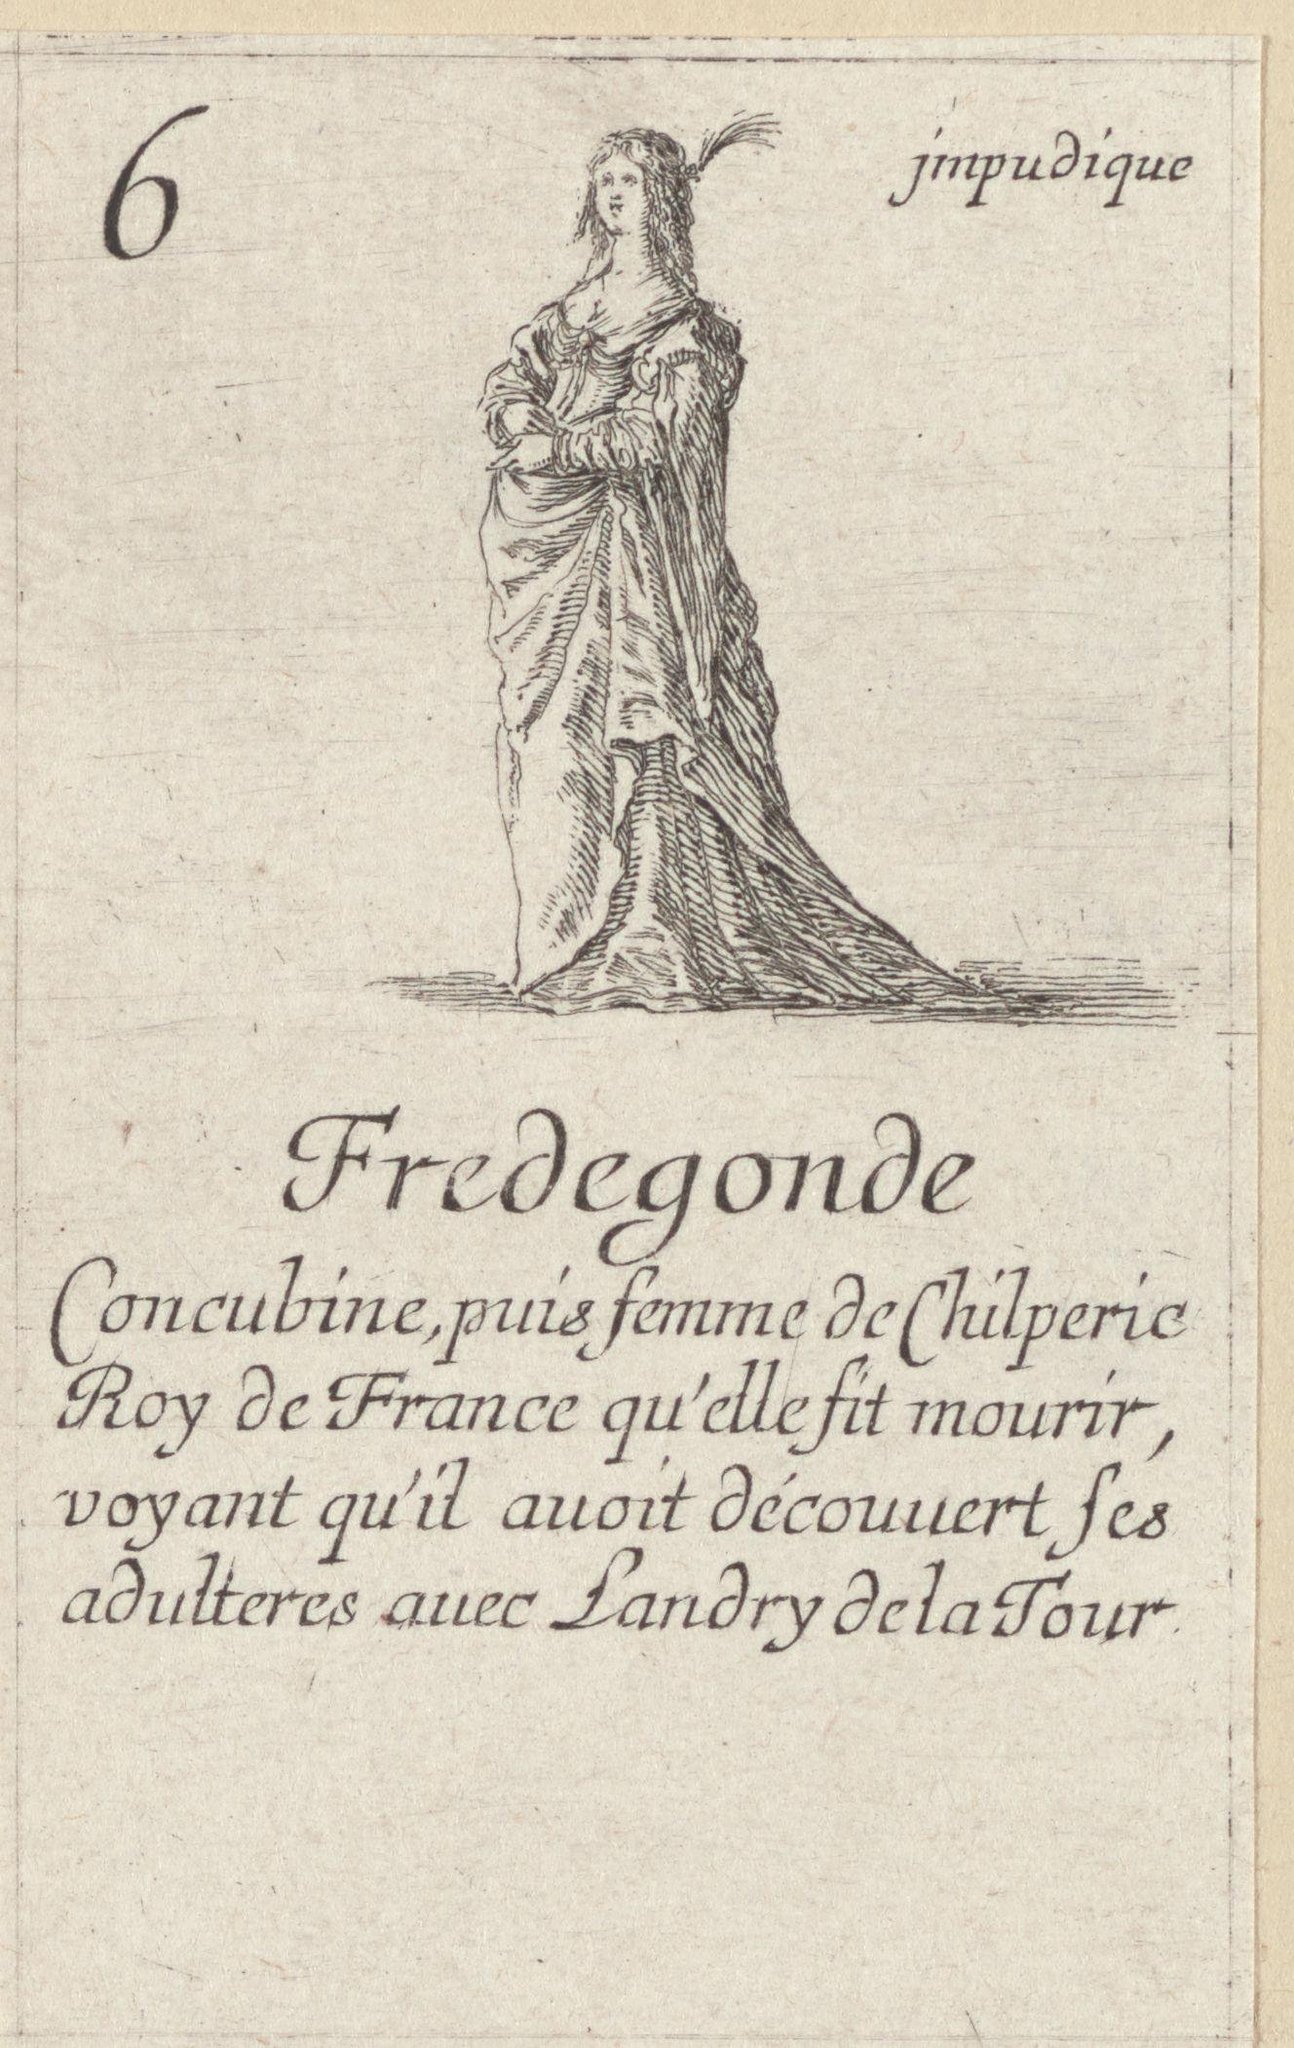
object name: print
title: Kaartspel met gerenommeerde heerseressen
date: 1620-1664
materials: paper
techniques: etching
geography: paris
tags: ruler, sovereign - bb - female ruler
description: Deze prent maakt deel uit van een kaartspel met 52 kaarten met voorstellingen van beroemde koninginnen. De serie is uitgedacht door Jean Desmarests de Saint-Sorlin in opdracht van Kardinaal Mazarin. Het kaartspel werd gemaakt voor de jonge Lodewijk XIV, samen met het Jeu des Fables, Jeu de la Géographie en Jeu des Rois de France.